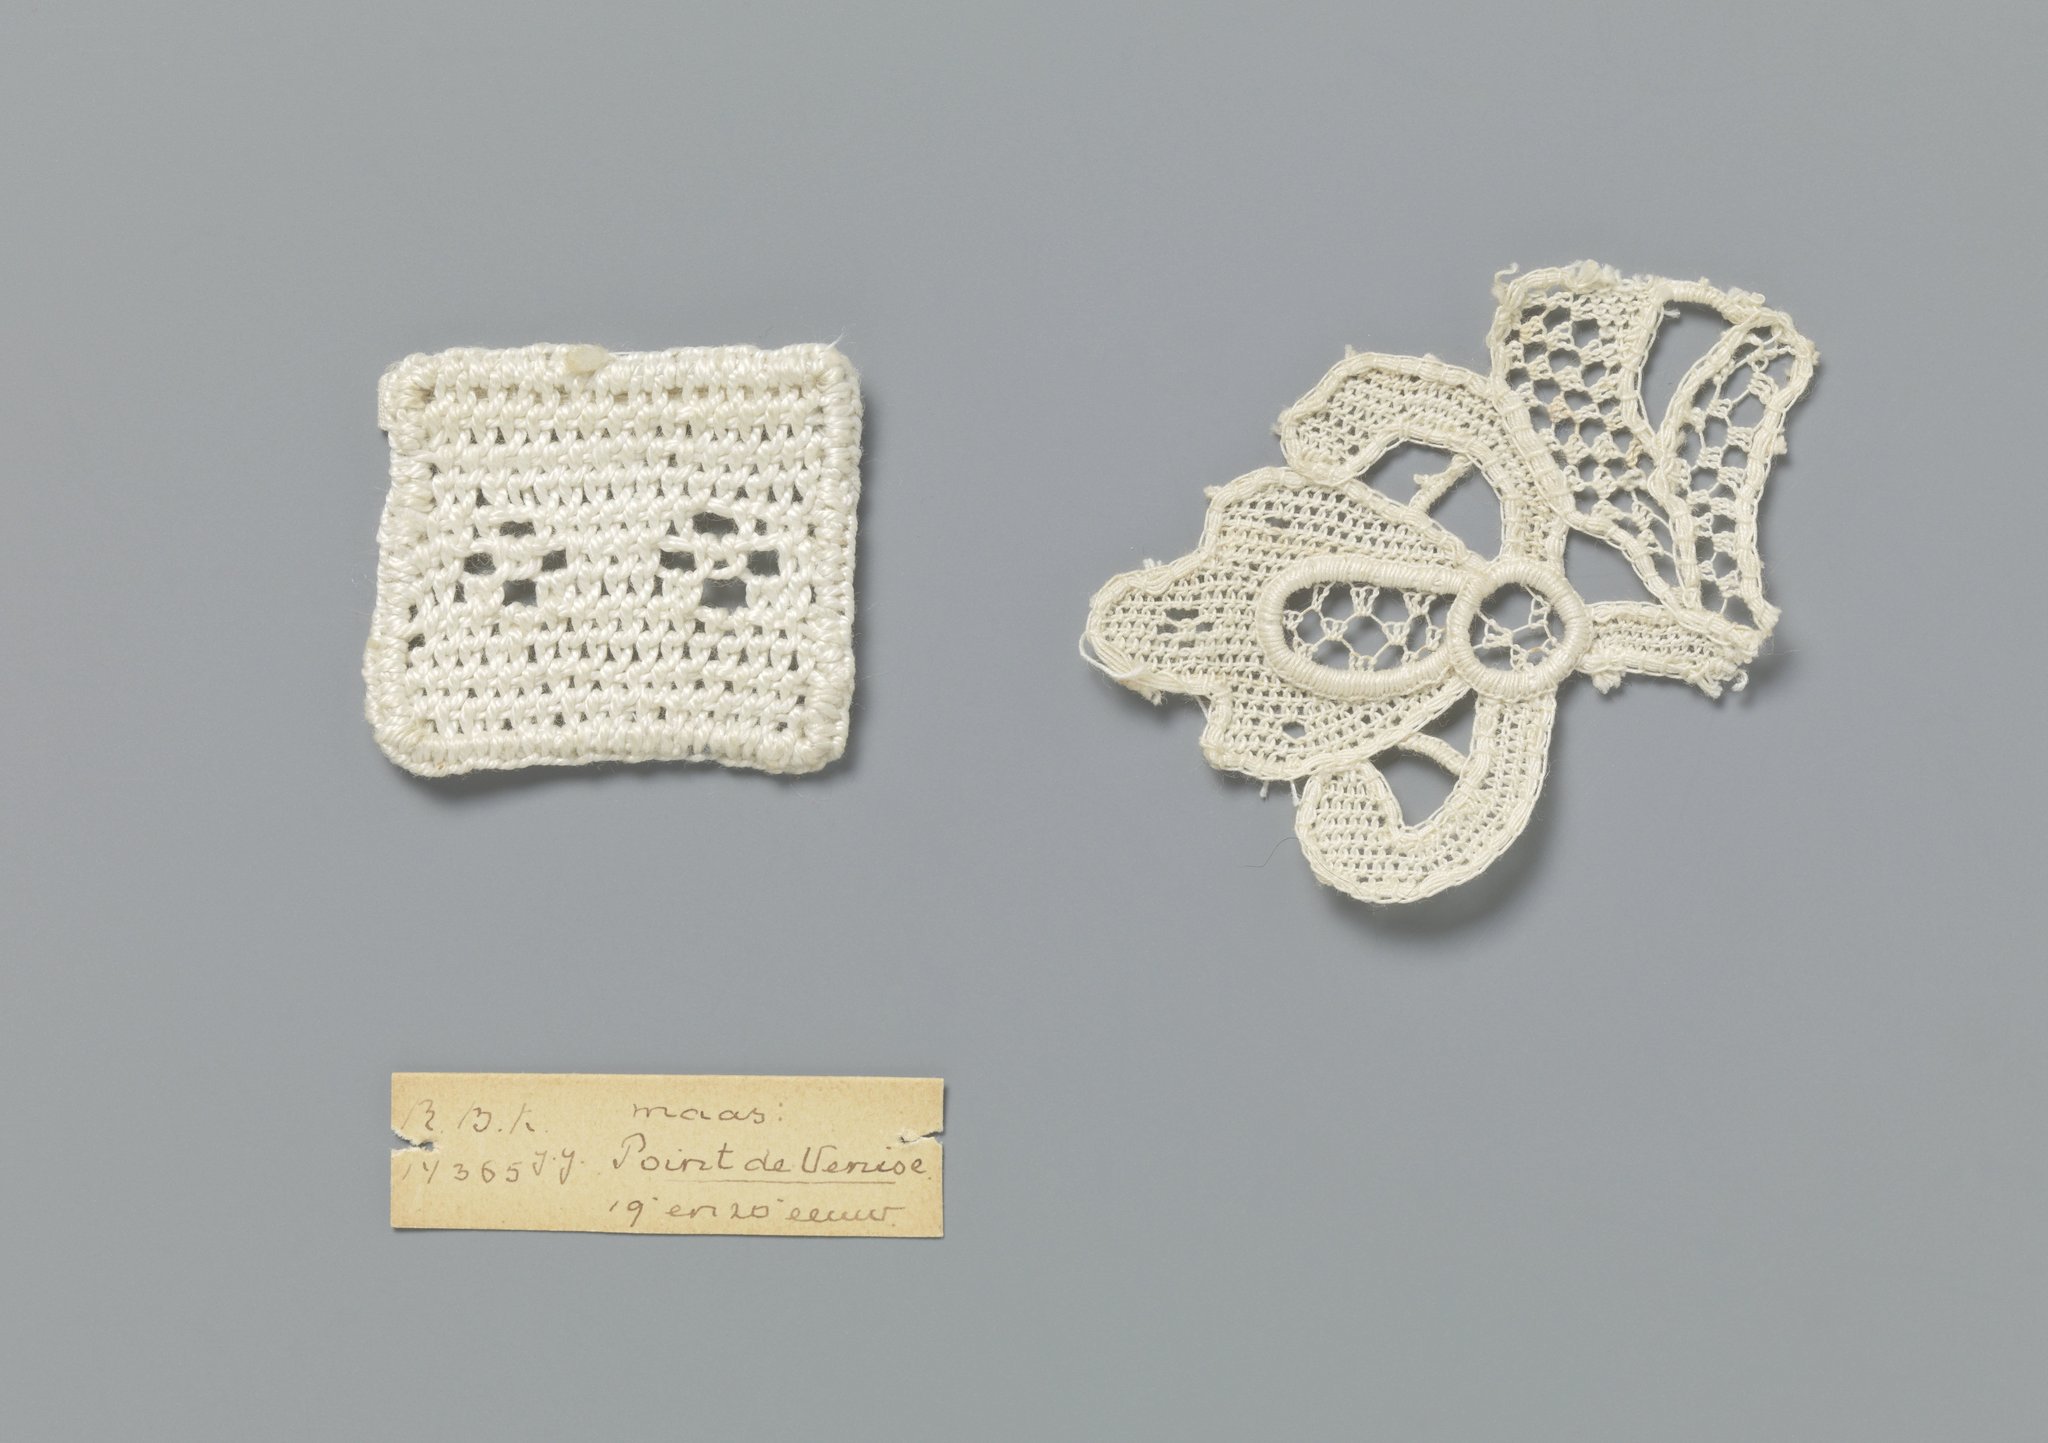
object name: sample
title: Staal naaldkant met uitsparingen in ruitvormige configuratie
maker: Anonymous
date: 1925-1929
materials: linen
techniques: needle lace, fabric stitch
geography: netherlands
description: Staal naturelkleurige naaldkant. Rechthoekig model. Een rechthoekig kader gemaakt met gefestonneerde draden, die zodoende een reliëfcontourlijn vormen, is opgevuld met stofsteken ('point de Venise'): festonsteken over horizontale spandraden. In het midden is een versiering gemaakt met rechthoekige uitsparingen. Het gaat om twee naast elkaar geplaatste configuraties van elk vier uitgespaarde rechthoekjes. Bij het staal hoort een fragment 19e-eeuwse of vroeg 20e-eeuwse Venetiaanse naaldkant waarin deze techniek is toegepast, waaronder ook in een variant waardoor een opengewerkt patroon met blokjes ontstaat.